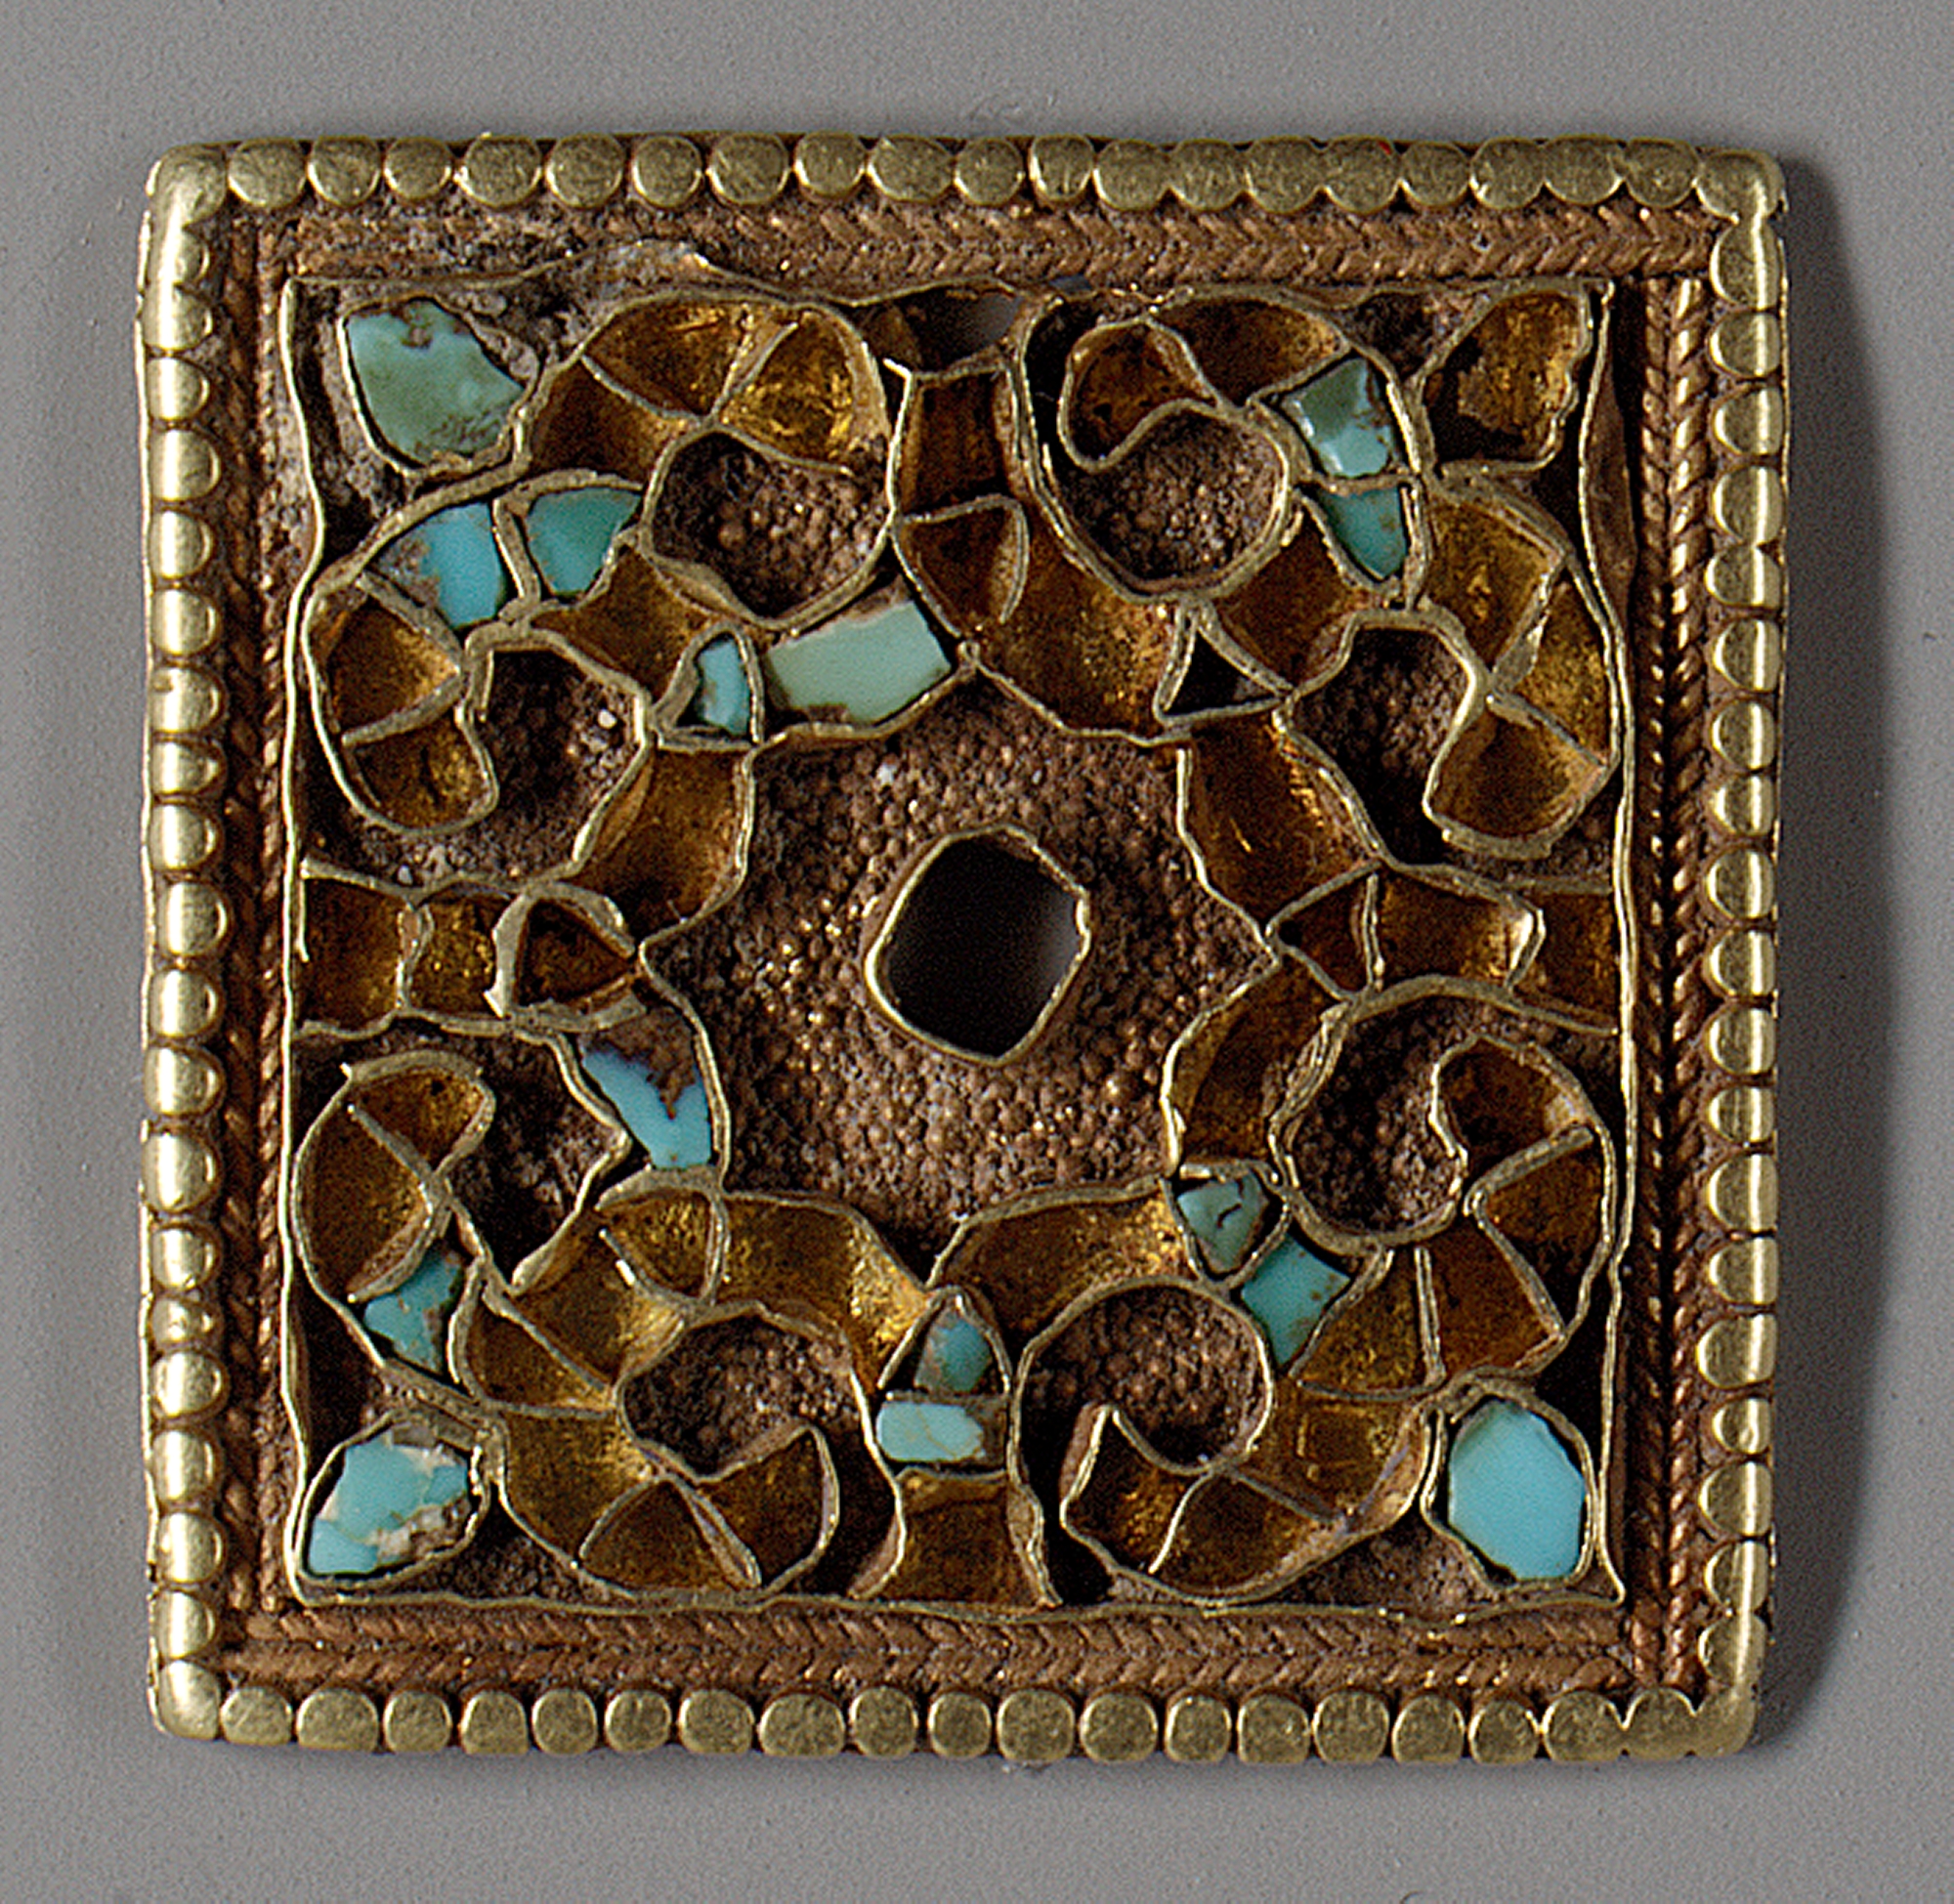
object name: plaque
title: Ornamented Plaques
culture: central asia or china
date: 601-900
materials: gold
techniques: inlay